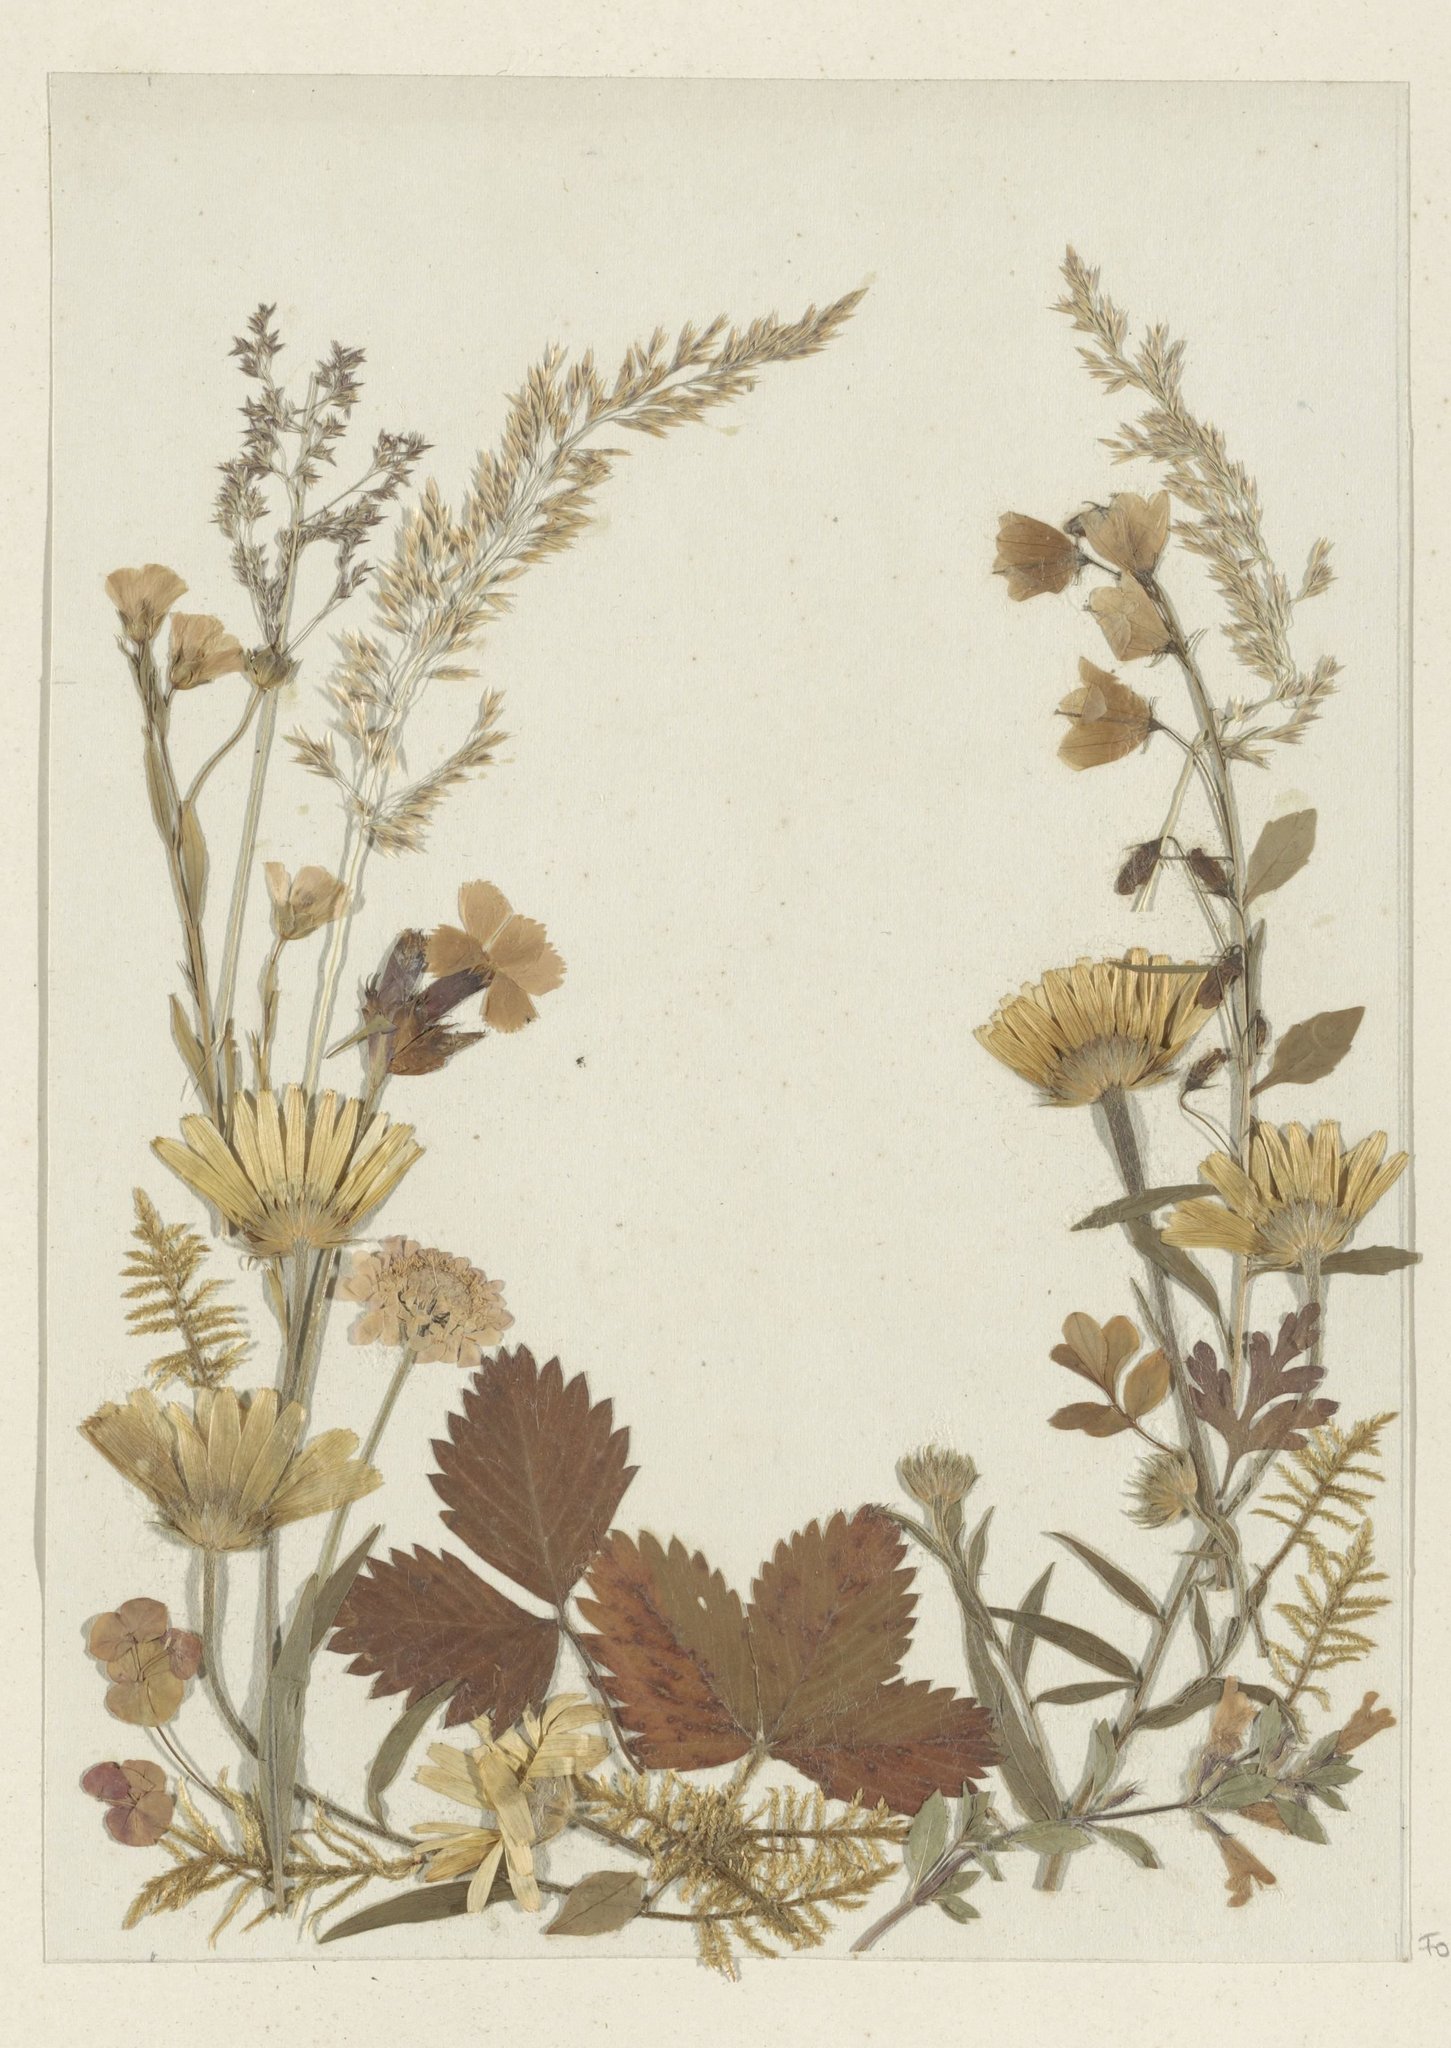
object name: album leaf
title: Collage van bloemen, vermoedelijk uit de Alpen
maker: Anonymous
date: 1860-1890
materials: flower, paper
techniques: collage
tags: dried flowers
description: Onderdeel van Reisalbum met foto's van Zwitserland, Oostenrijk, Italië en Duitsland.